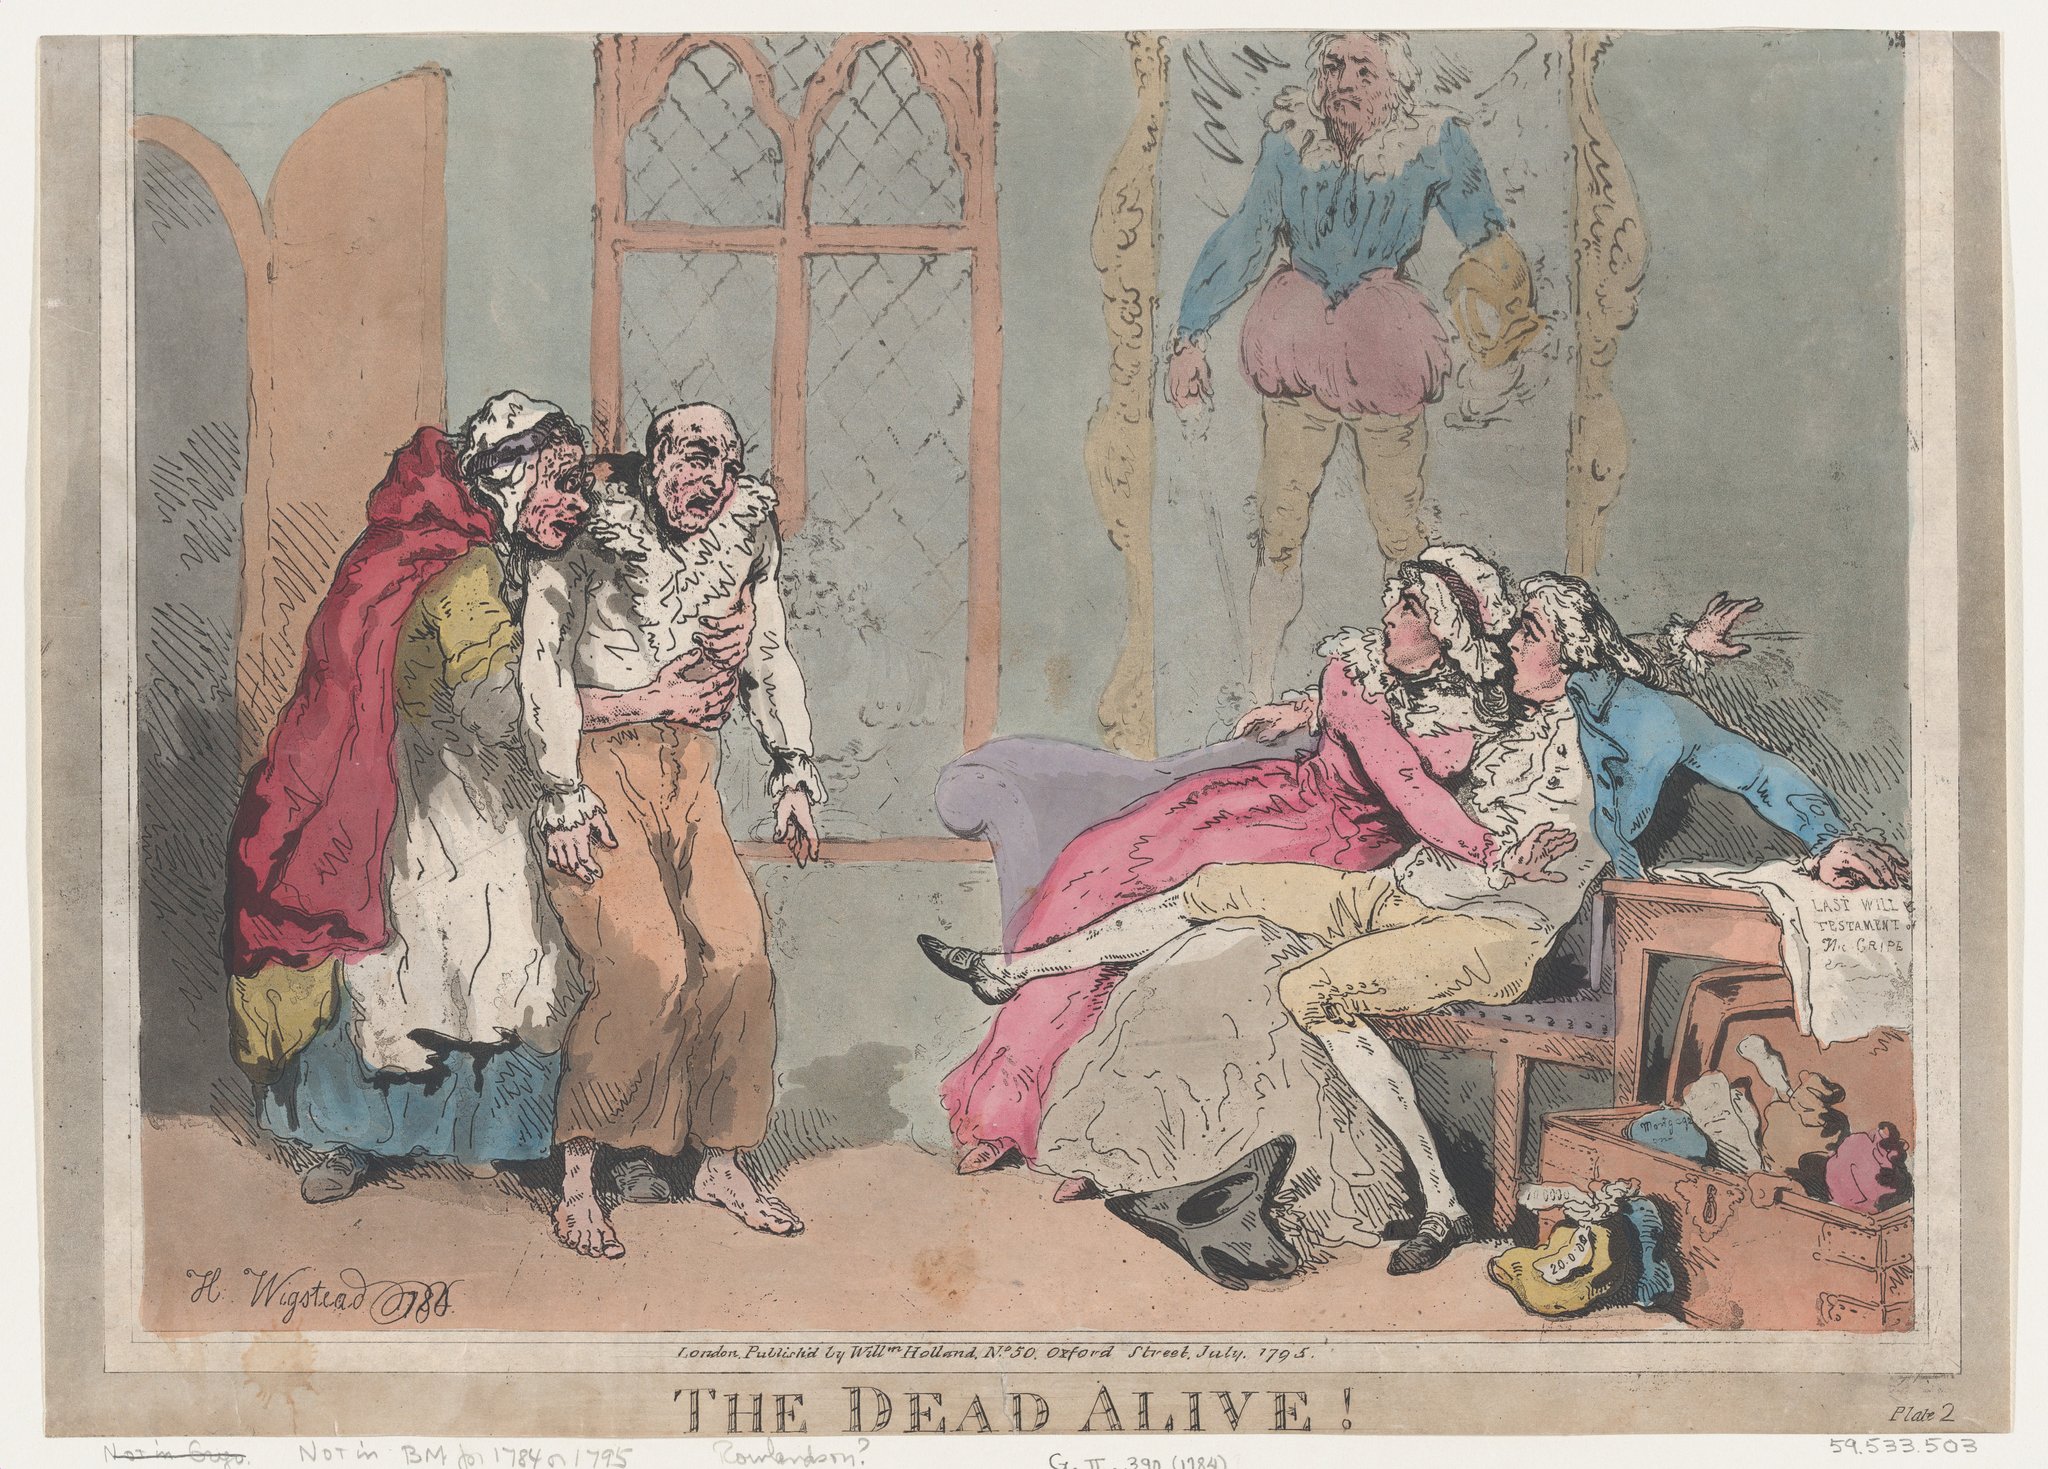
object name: print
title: The Dead Alive!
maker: thomas rowlandson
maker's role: artist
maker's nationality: british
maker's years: 1757-1827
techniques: etching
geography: london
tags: satire,fear,men,women